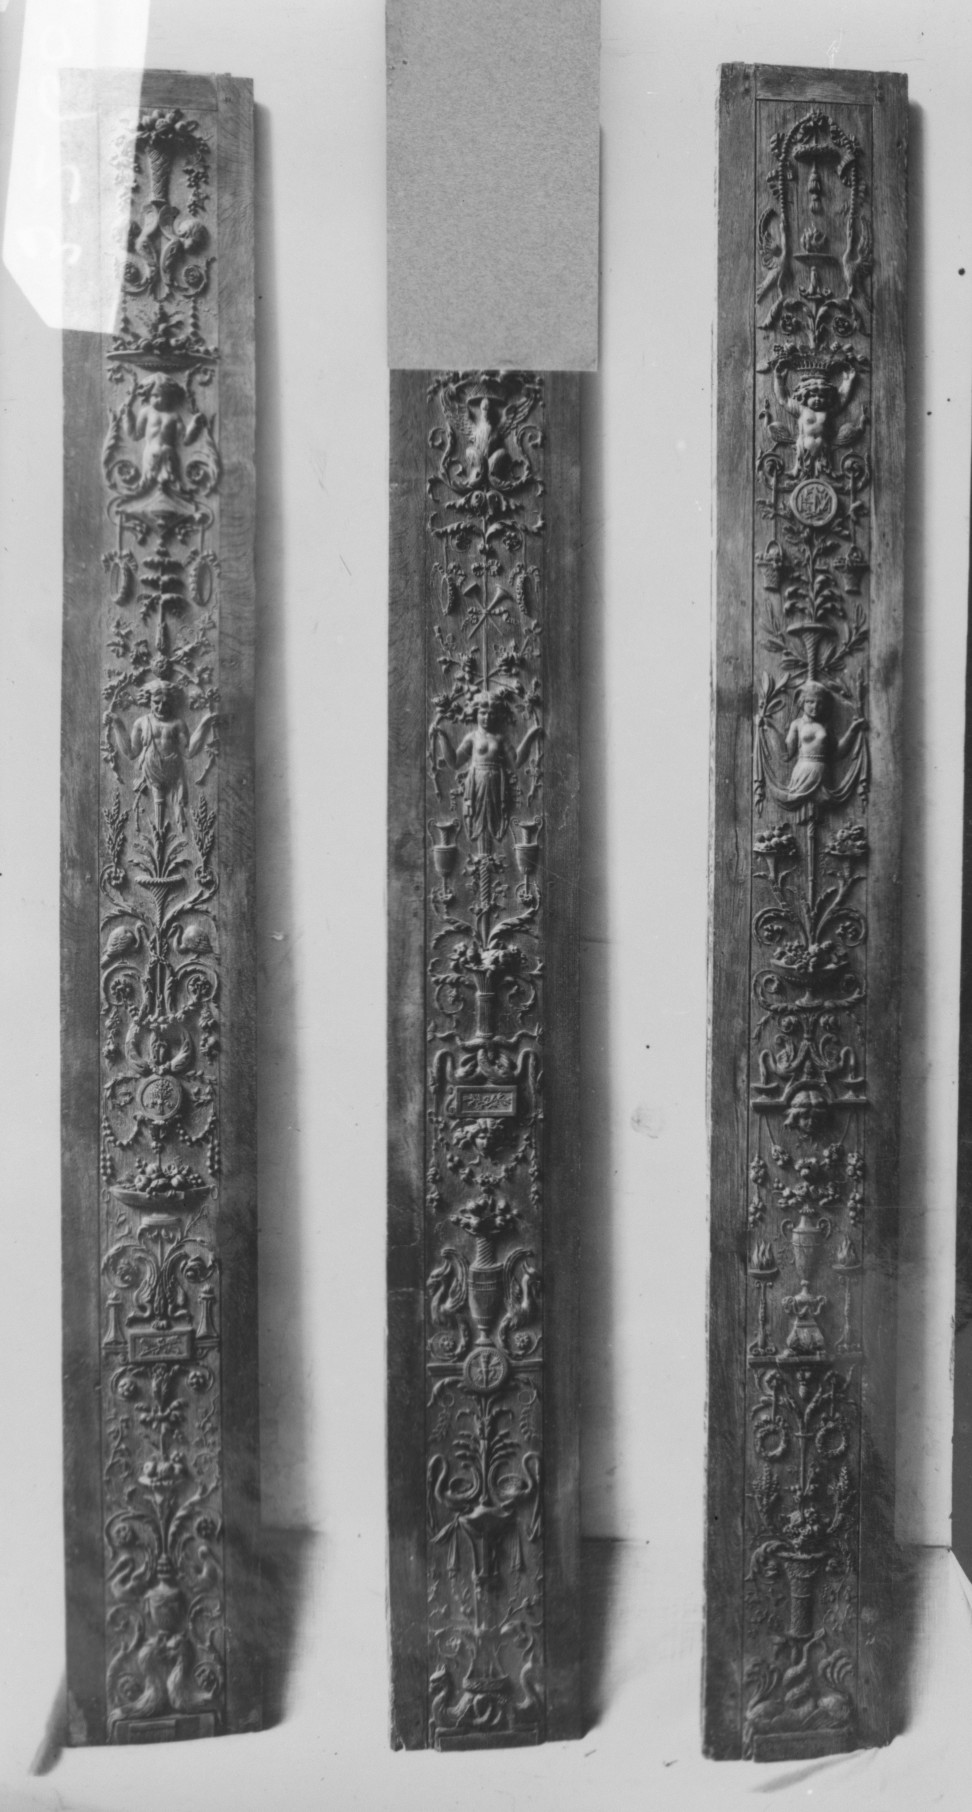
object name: pilaster panel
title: Pilaster panel (part of a set of eight)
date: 1701-1800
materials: wood